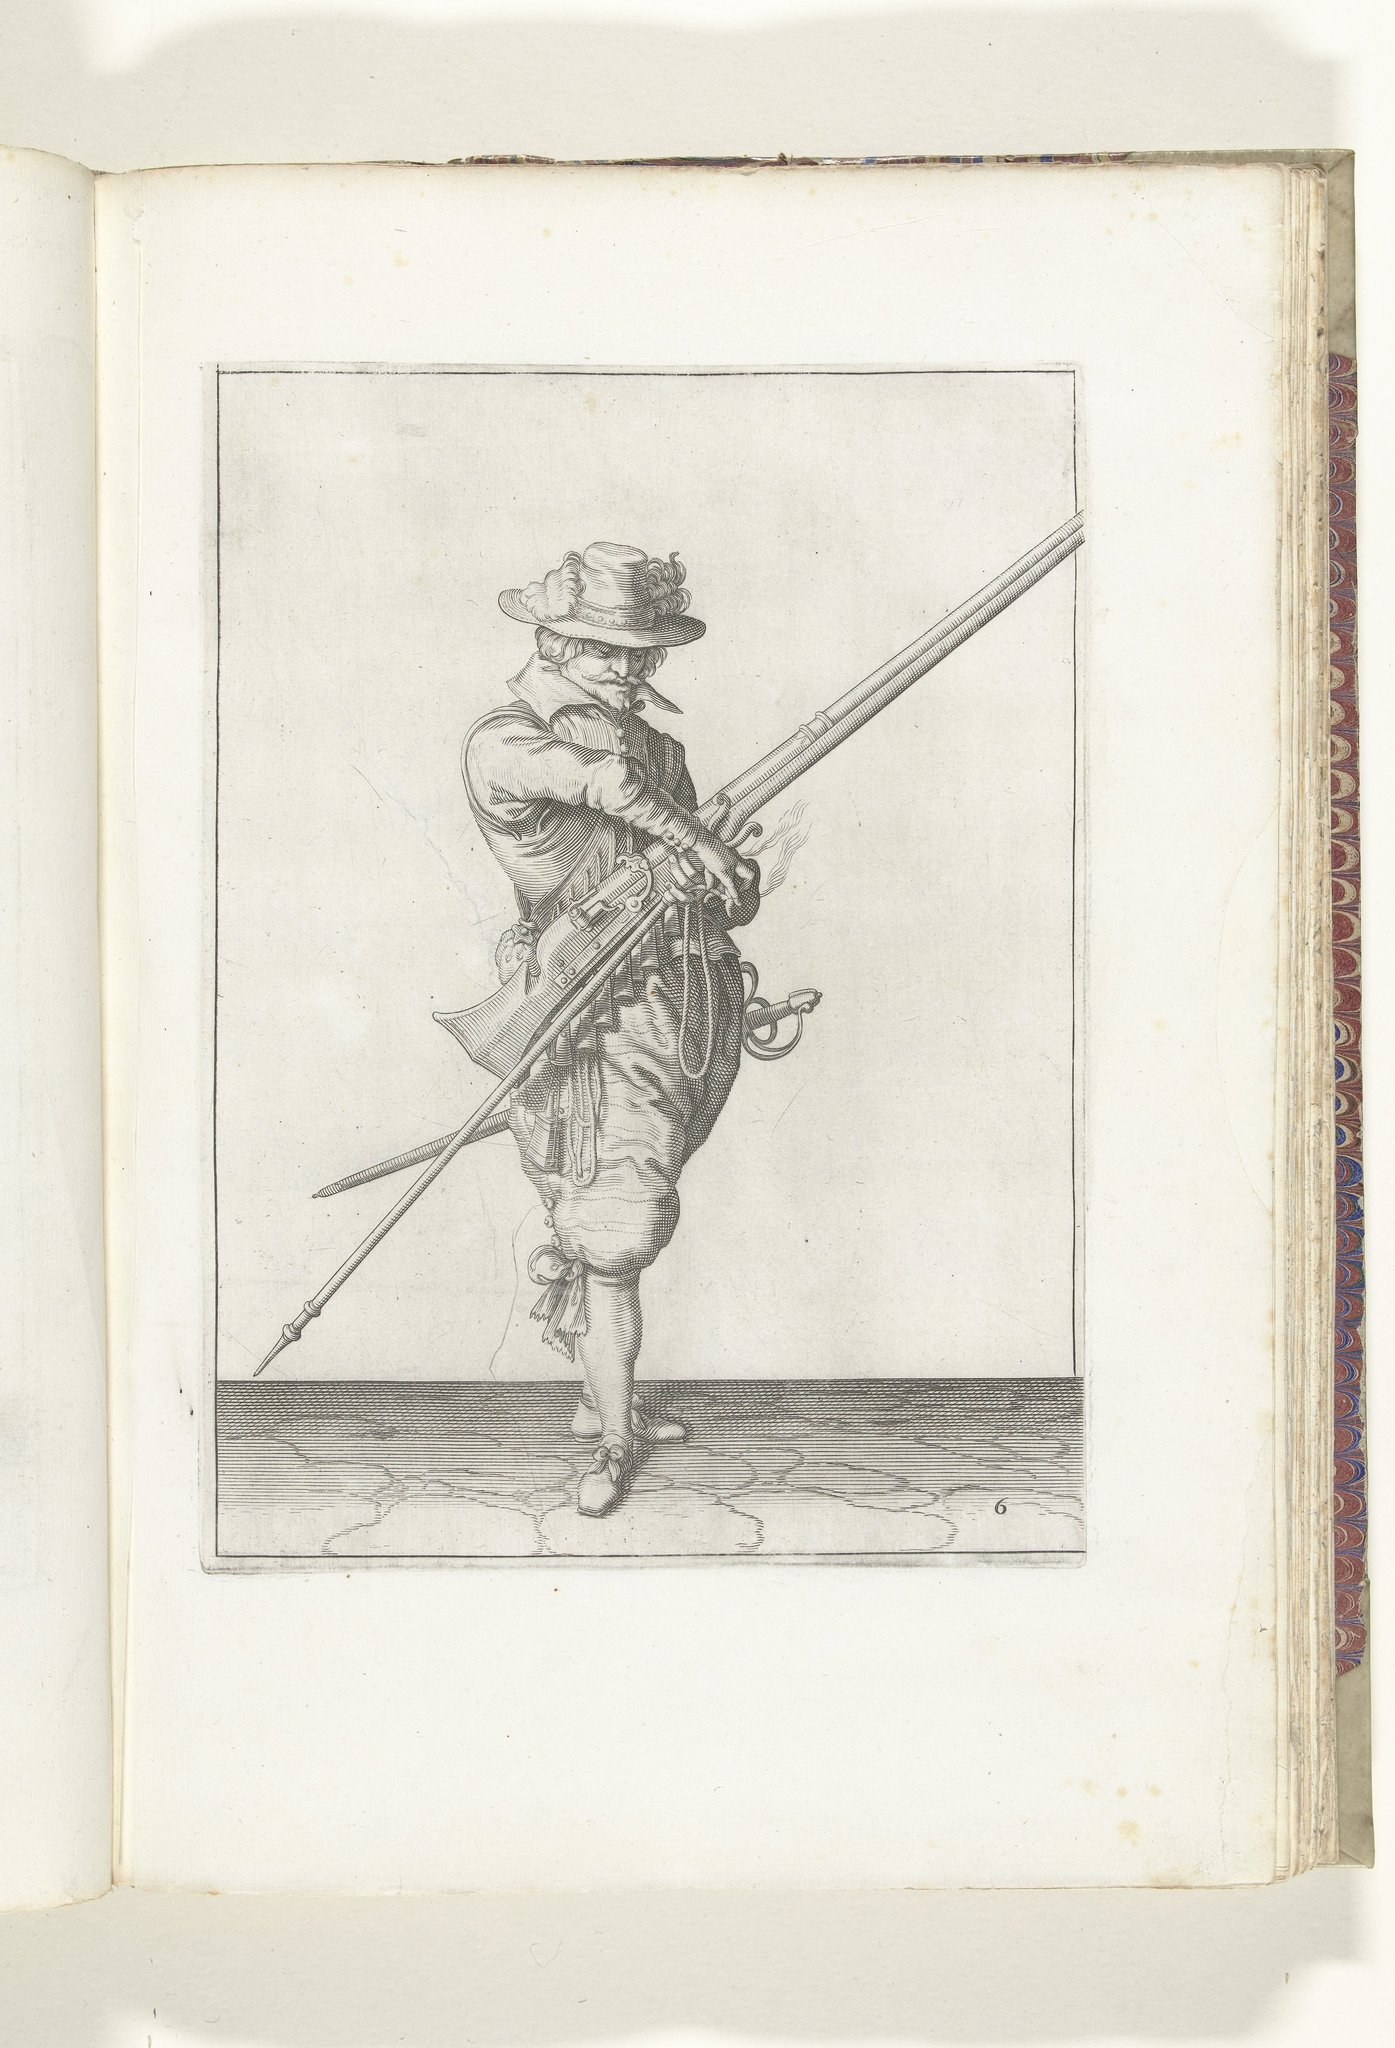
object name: print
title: Soldaat met een musket die zijn lont pakt (nr. 6), ca. 1600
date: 1597-1607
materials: paper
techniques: engraving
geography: amsterdam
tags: the hague, maurice (prince of orange), handling of weapons ~ military training, weapons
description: Een soldaat, ten voeten uit, naar rechts, die een musket (een bepaald type vuurwapen) met zijn linkerhand vasthoudt (nr. 6), ca. 1600. In zijn linkerhand behalve het musket ook een furket (musketvork) en een brandende lont. Met zijn rechterhand pakt hij deze lont. Plaat 6 in de instructies voor het hanteren van het musket: Corte onderrechtinghe op de figuerlicke afbeeldinghe, soo veel aengaet het recht ghebruyck van Musquet. Onderdeel van de illustraties in: J. de Gheyn, Wapenhandelinghe van Roers Musquetten ende spiessen, Amsterdam, 1608. Krijgswezen rond 1600.